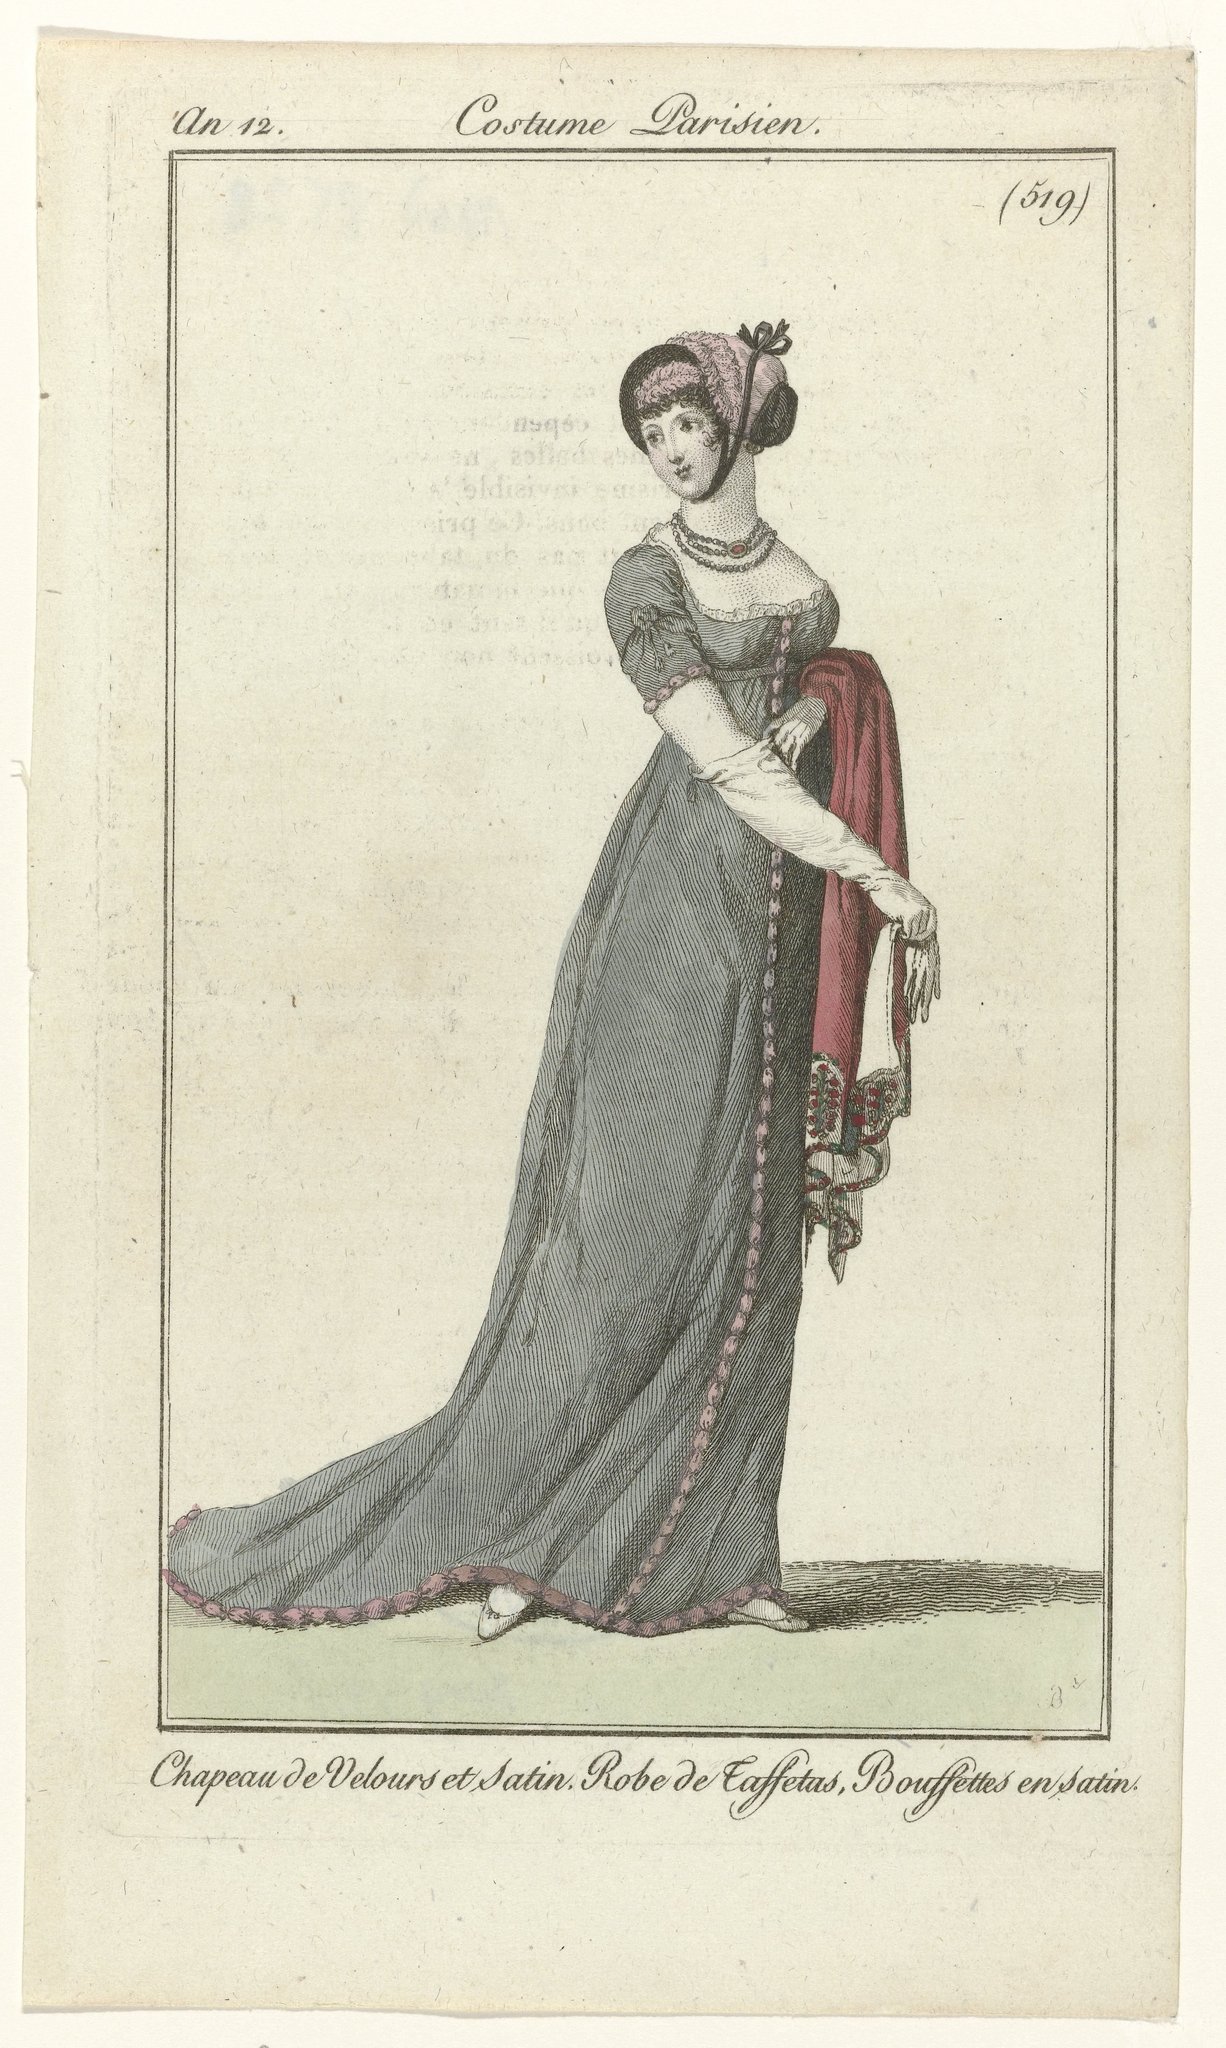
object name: fashion print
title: Journal des Dames et des Modes, Costume Parisien, 17 décembre 1803, An 12 (519) : Chapeau de Velours (...)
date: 1802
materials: paper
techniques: engraving, hand coloring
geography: paris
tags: gloves, mittens (long gloves) (+ women's clothes), clothing for the upper part of the body (shawl) (+ women's clothes), gloves, mittens, etc. (+ dressing, putting on clothes), fashion plates, head-gear: hat (+ women's clothes), shoes, sandals (+ women's clothes), dress, gown (+ women's clothes), necklace (+ women's clothes)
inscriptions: caption: ‘Chapeau de Velours et Satin. Robe de Taffetas, Bouffettes en Satin.’, title: ‘Costume Parisien.’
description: Hoed van fluweel en satijn. Japon van tafzijde met korte mouwen en sleep. 'Bouffettes' van satijn. Verdere accessoires: collier bestaande uit twee snoeren, lange handschoenen, sjaal om de linkerarm, platte schoenen. De prent maakt deel uit van het modetijdschrift Journal des Dames et des Modes, uitgegeven door Pierre de la Mésangère, Parijs, 1797-1839.